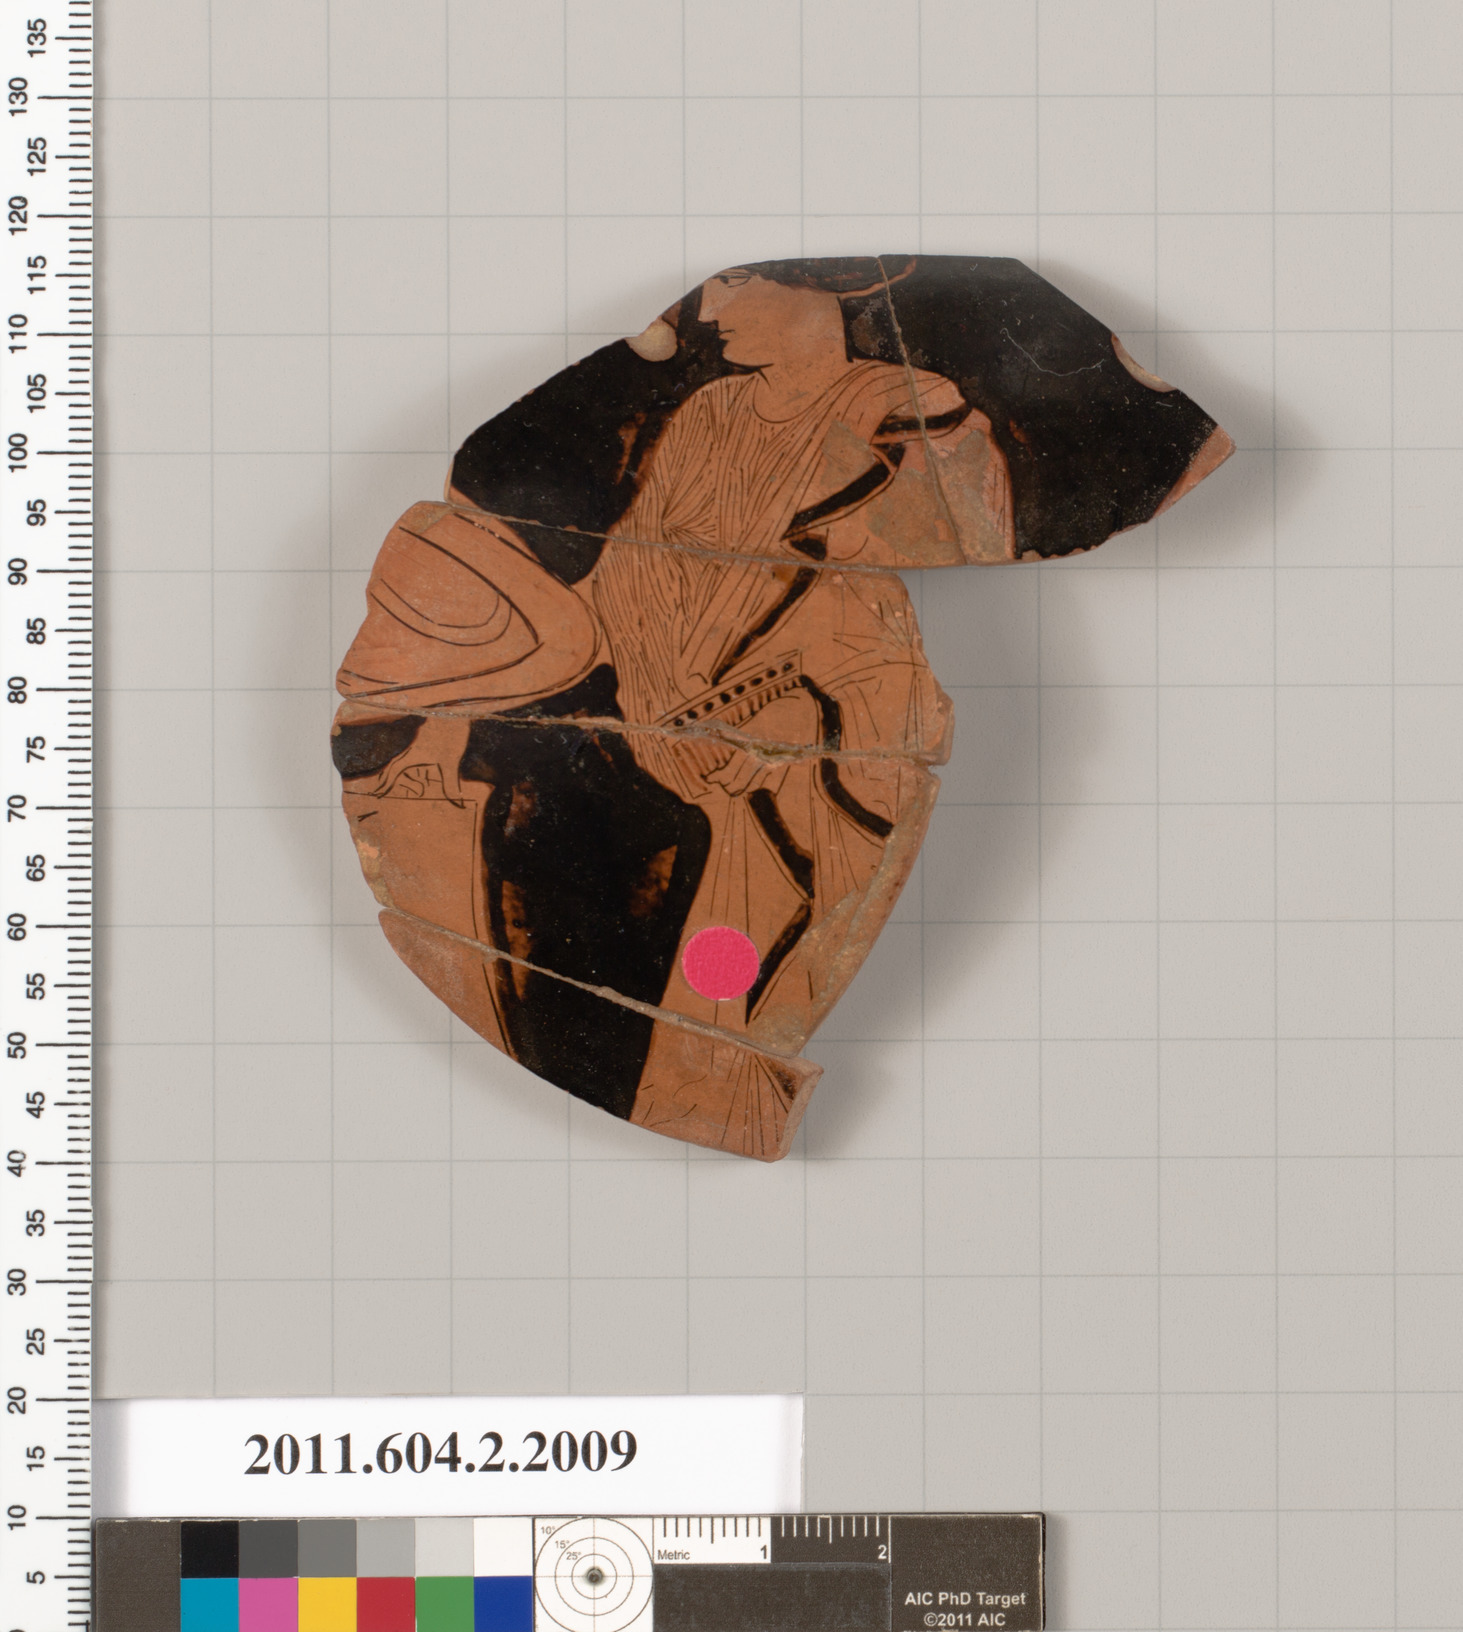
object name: lekythos fragment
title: Terracotta fragment of a squat lekythos (oil flask)?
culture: greek, attic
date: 450-426 BCE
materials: terracotta